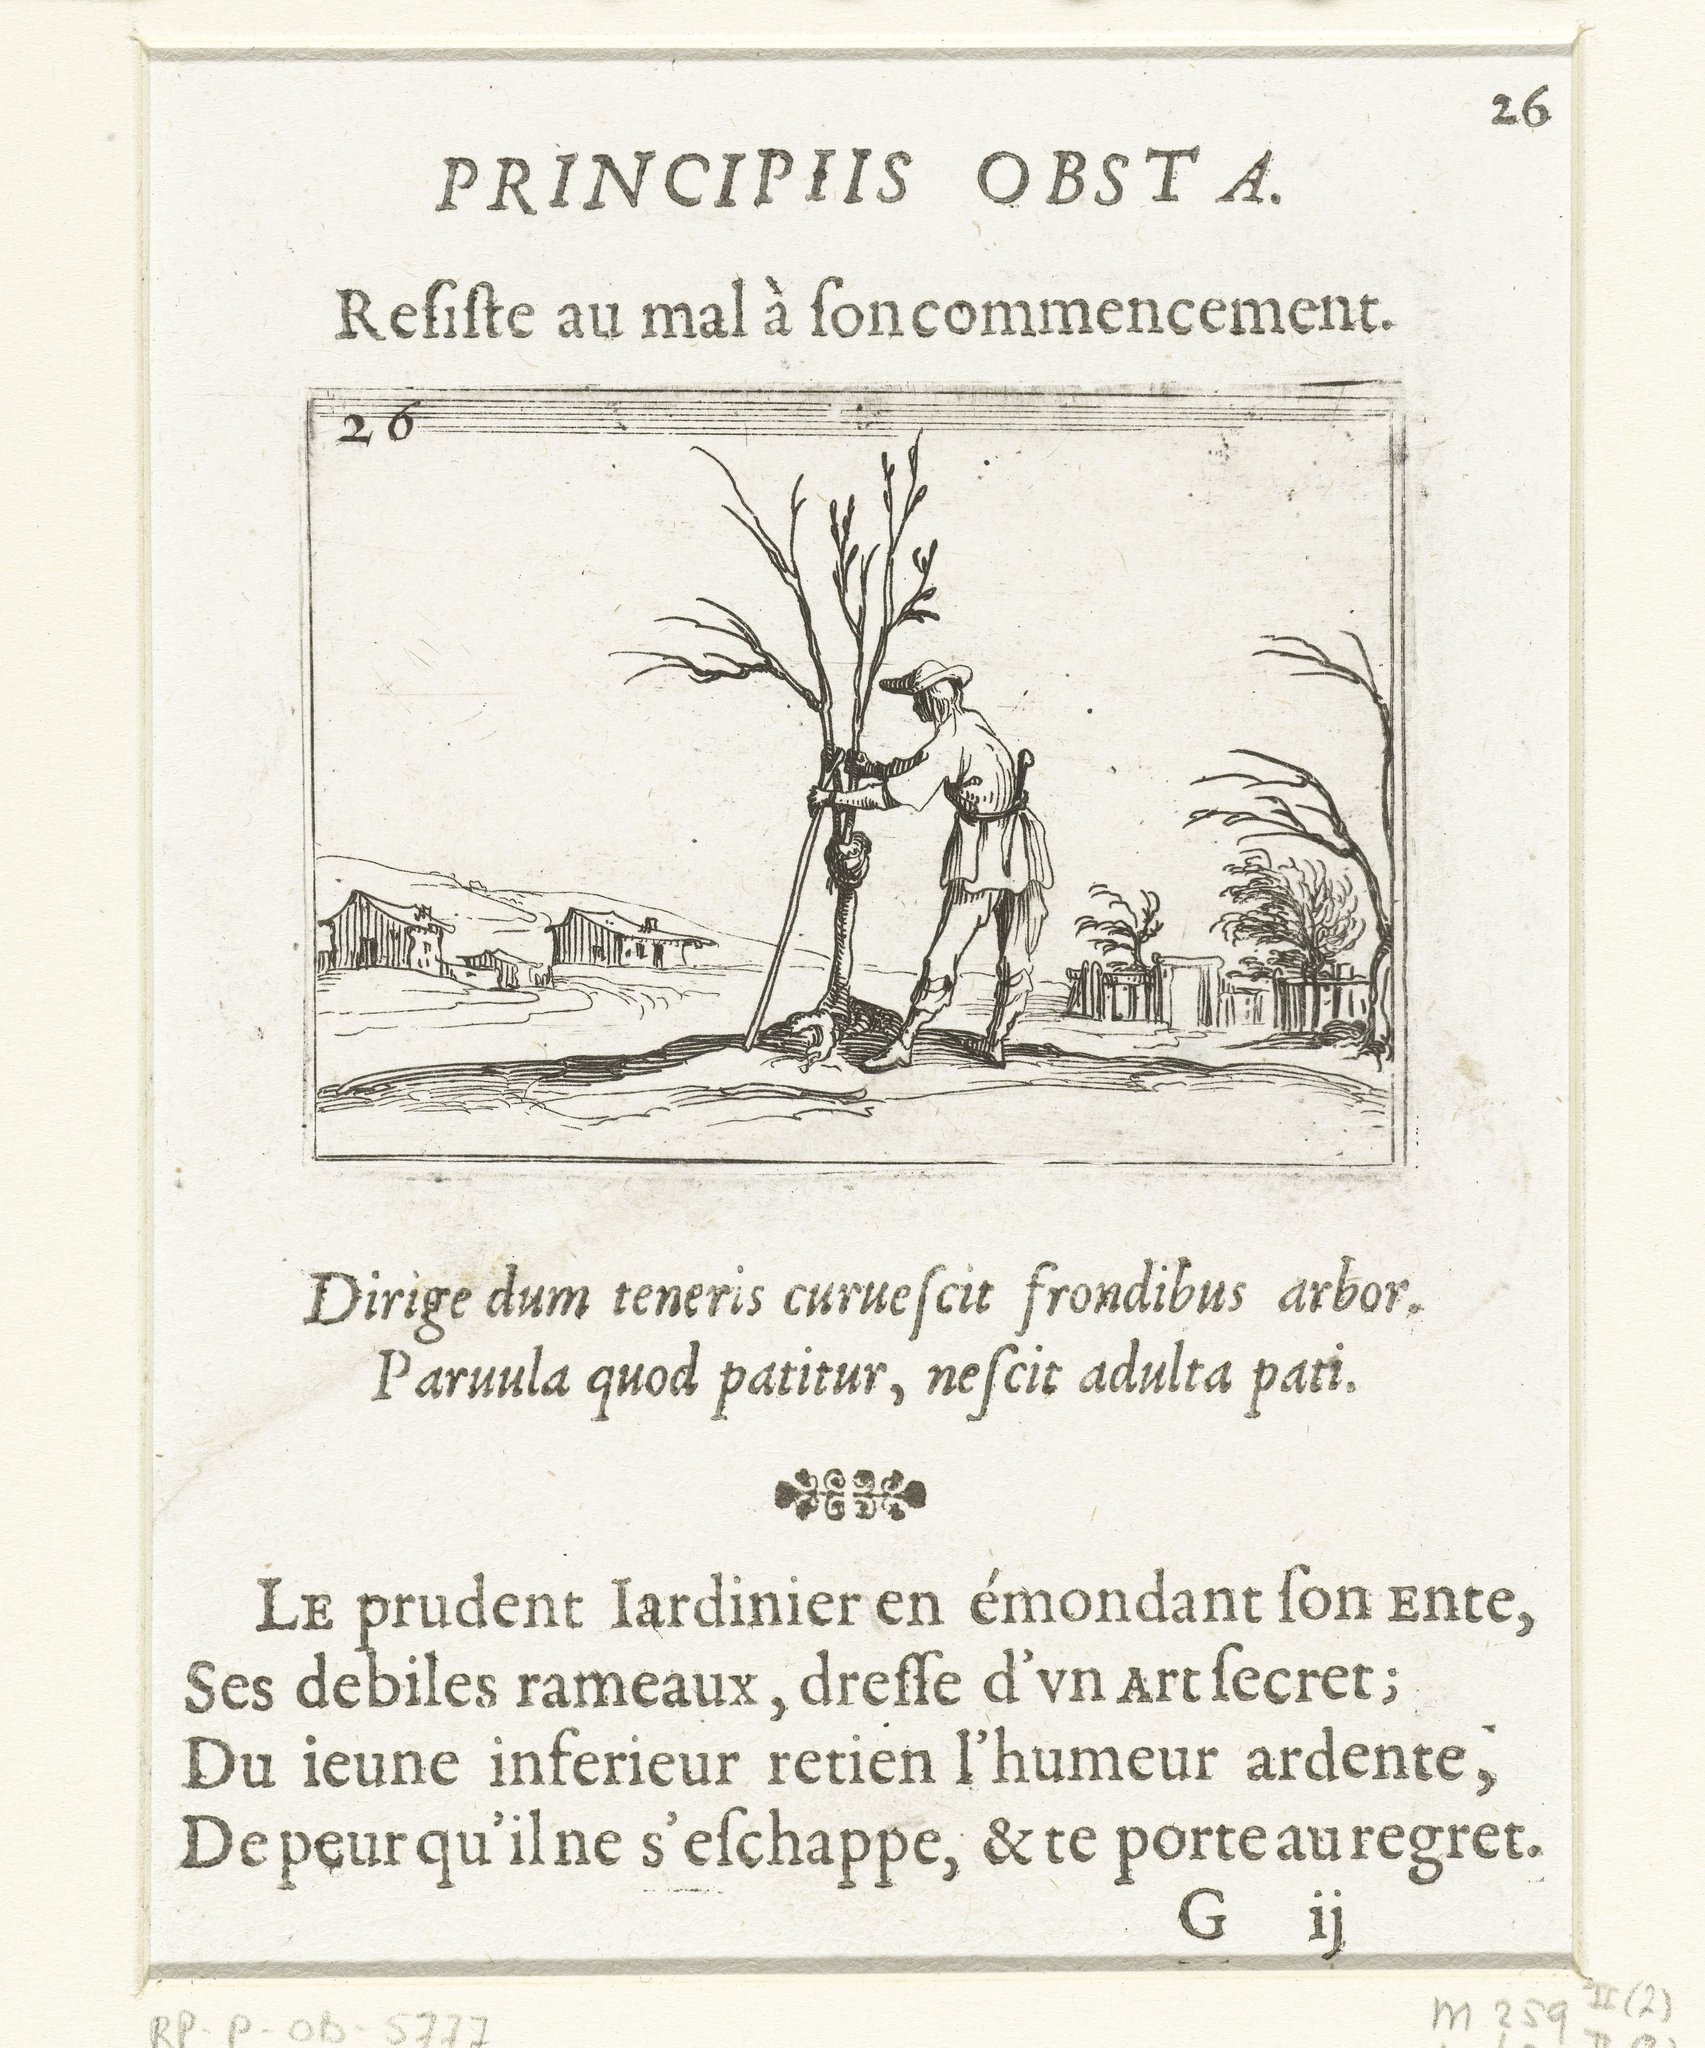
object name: cognizance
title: Kloosterleven in emblemen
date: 1621-1635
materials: paper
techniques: etching, letterpress printing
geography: paris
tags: trees, gardening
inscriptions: collector's mark: Lugt 240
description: Voorstelling van een tuinman die een ondersteunende stok plaatst bij een jonge boom. Boven en onder deze prent Latijnse en Franse teksten in boekdruk. Dit blad is onderdeel van de embleemserie 'Kloosterleven in emblemen'. De tweede staat van deze serie behelst naast een geïllustreerde titelpagina en 26 emblemen nog een titelpagina en een blad met opdracht, beide in boekdruk zonder afbeelding.